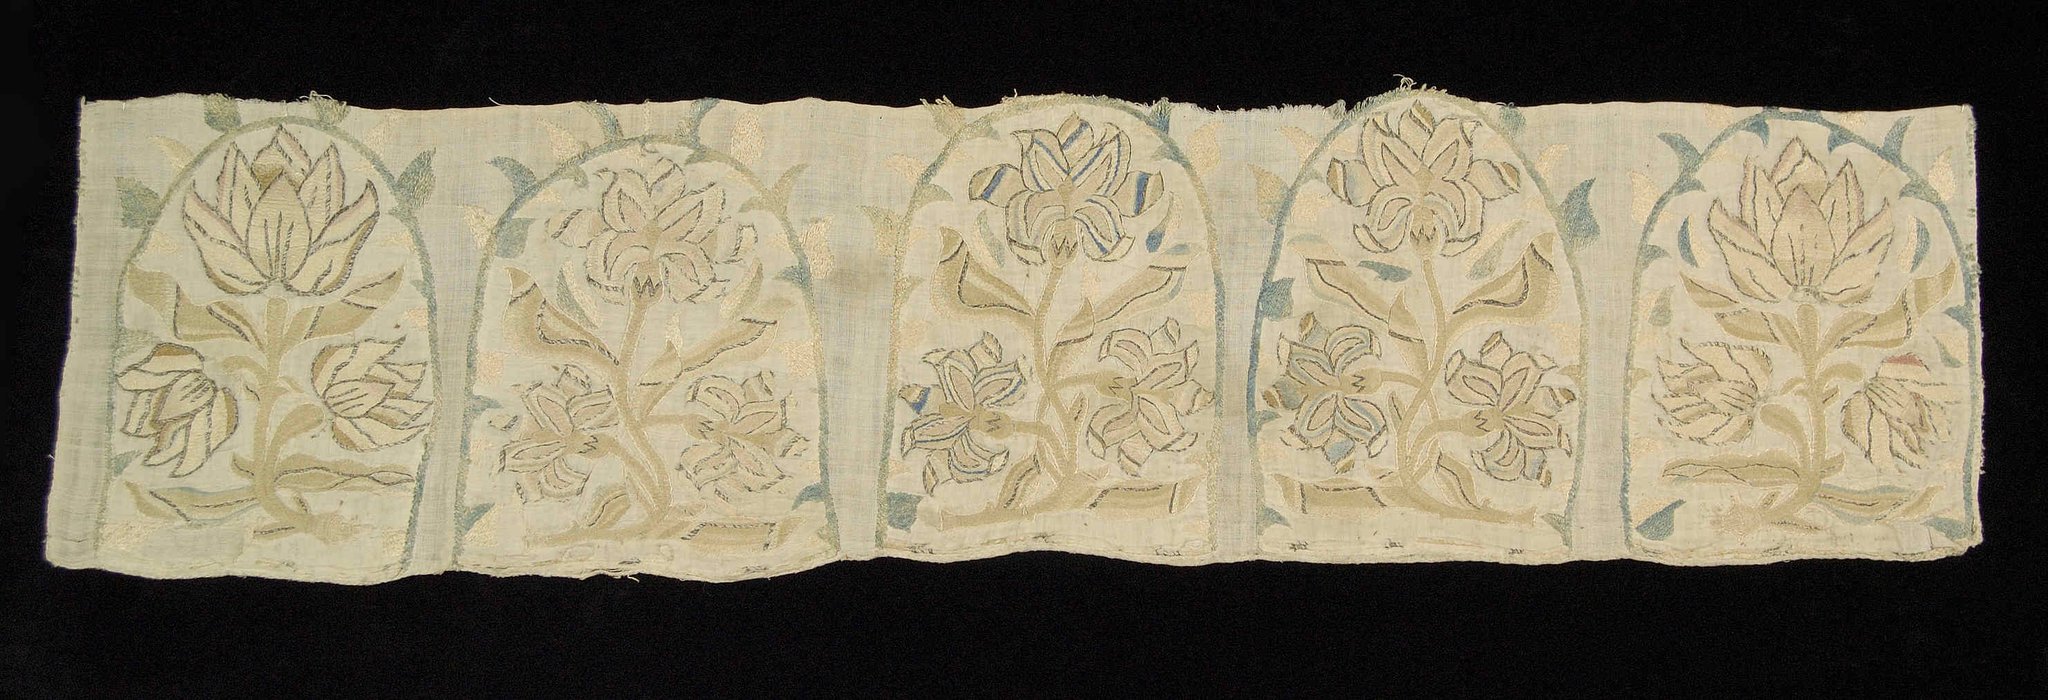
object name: textile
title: Fragment of a shirt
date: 1776-1800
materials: linen, metal, silk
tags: flowers,leaves